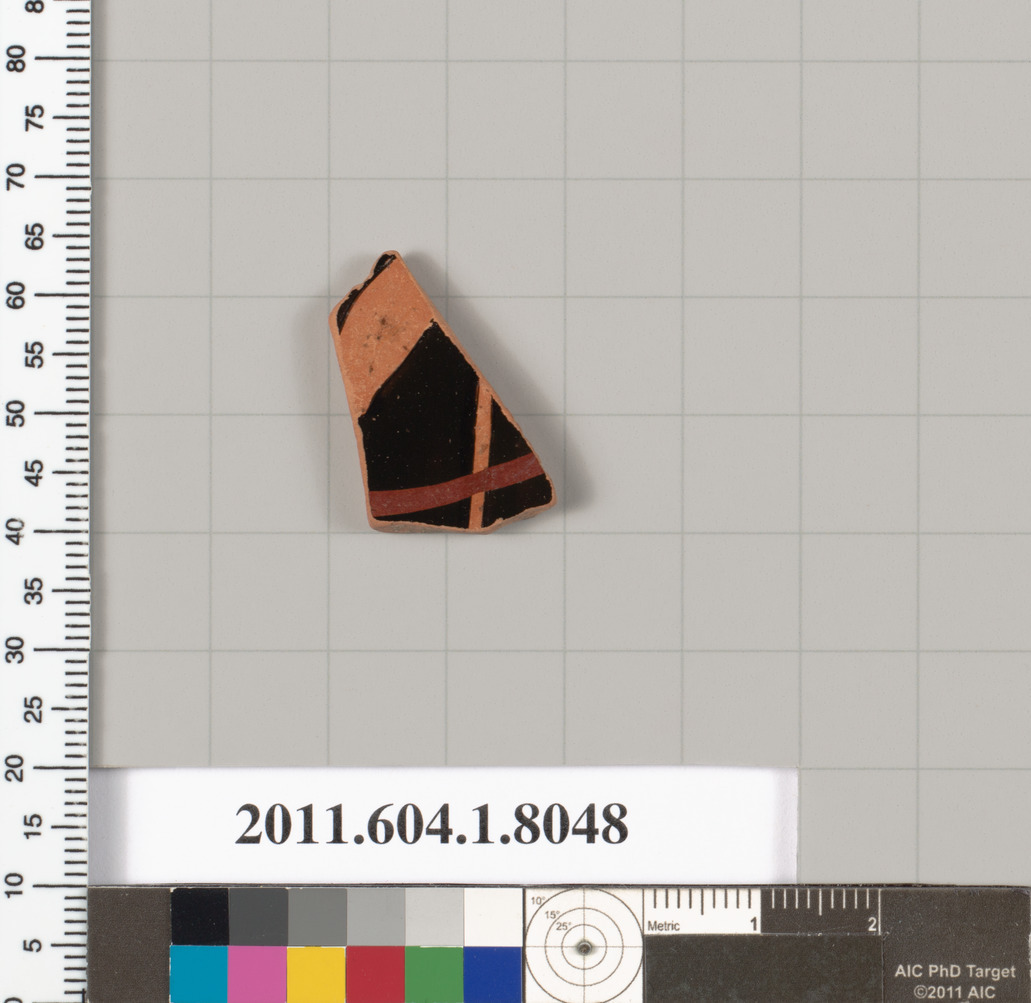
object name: kylix fragment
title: Terracotta fragment of a kylix (drinking cup)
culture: greek, attic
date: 510-490 BCE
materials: terracotta